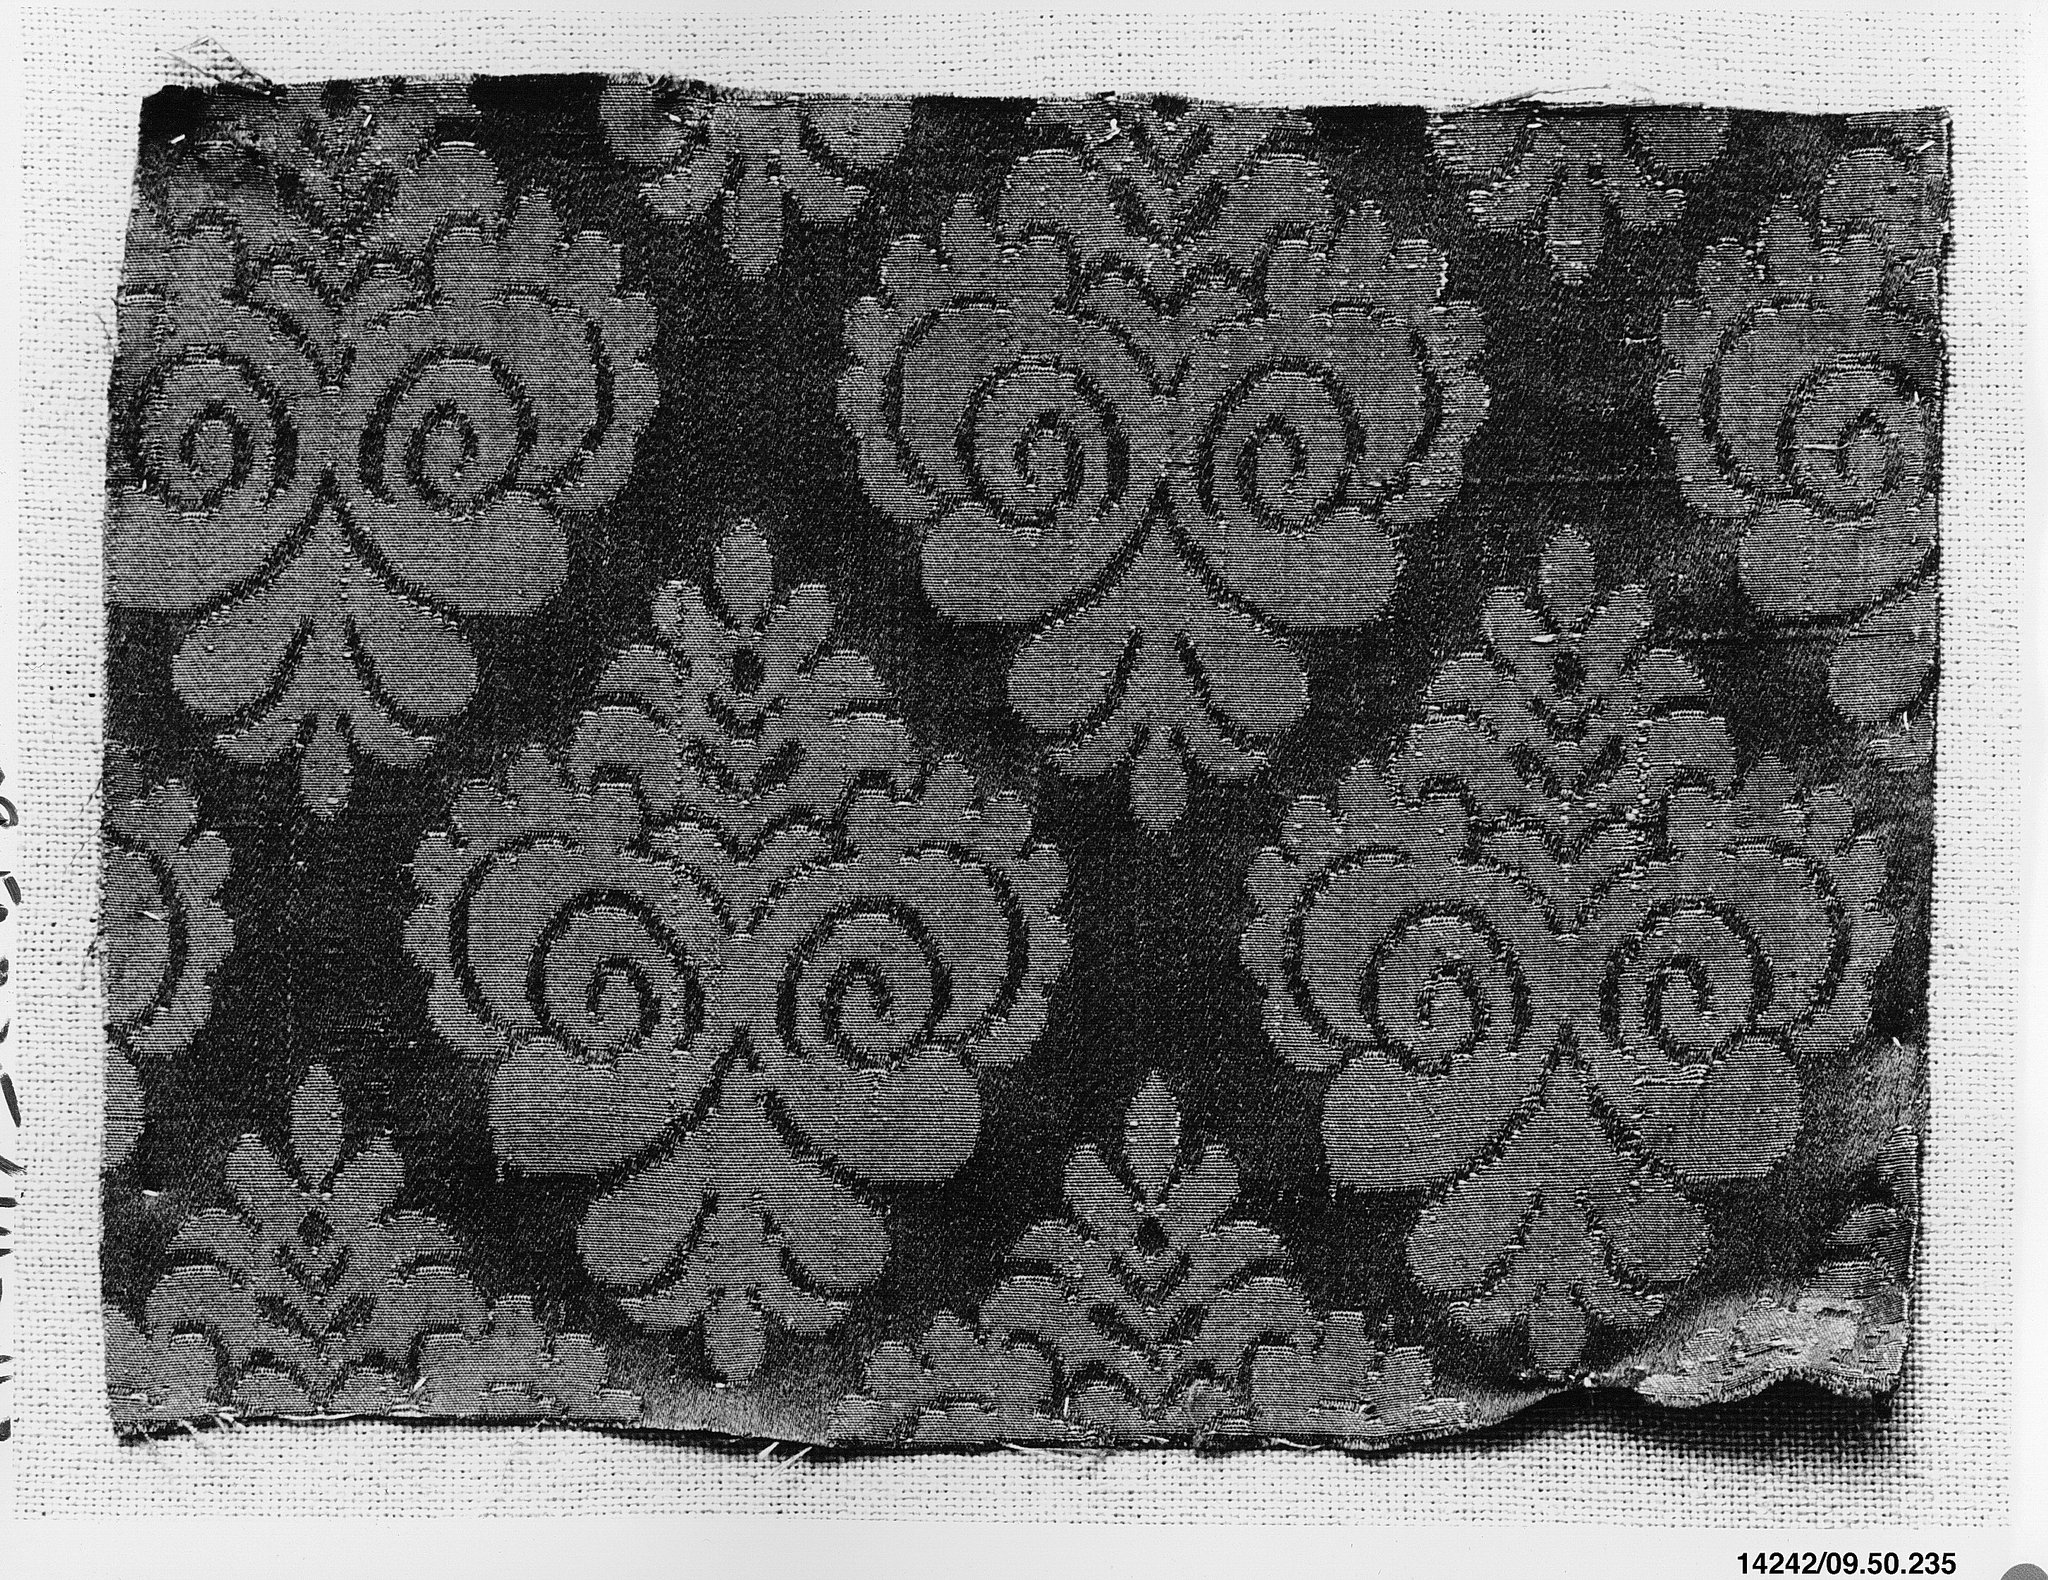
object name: piece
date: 1501-1600